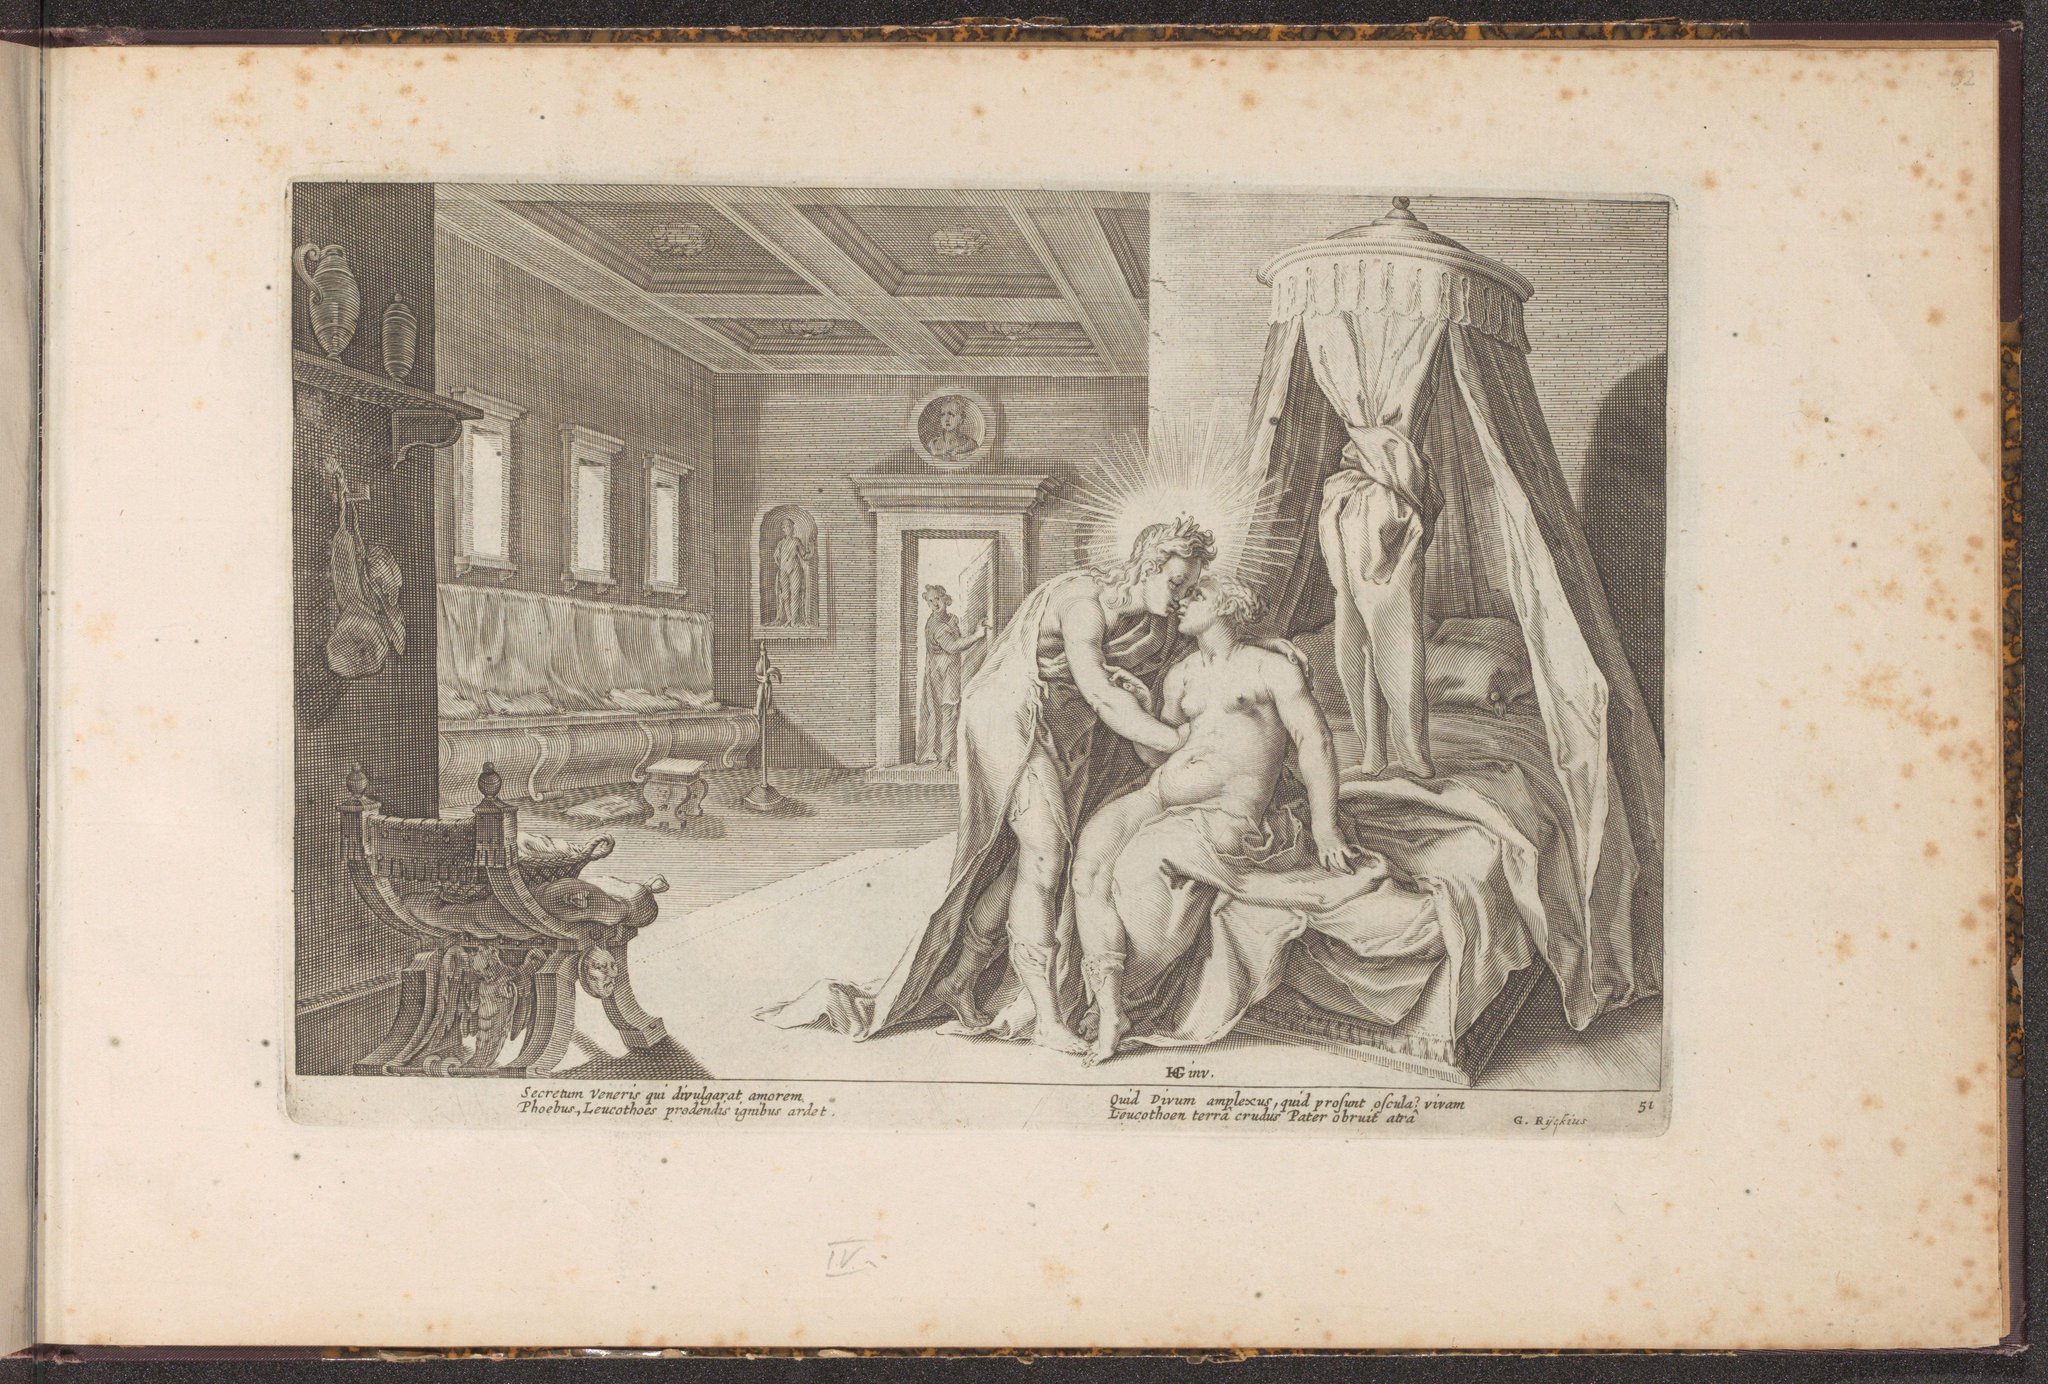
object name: album leaf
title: Herscheppingen van P. Ovidius Naso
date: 1615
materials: paper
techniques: engraving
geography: amsterdam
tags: apollo, possibly in the guise of an old woman, wooing leucothea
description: Apollo (of Helios) omarmt Leucothea, zittend op haar bed. Bij de deur worden zij bespied. Onder de voorstelling twee keer twee versregels in het Latijn. De prent maakt deel uit van een album.